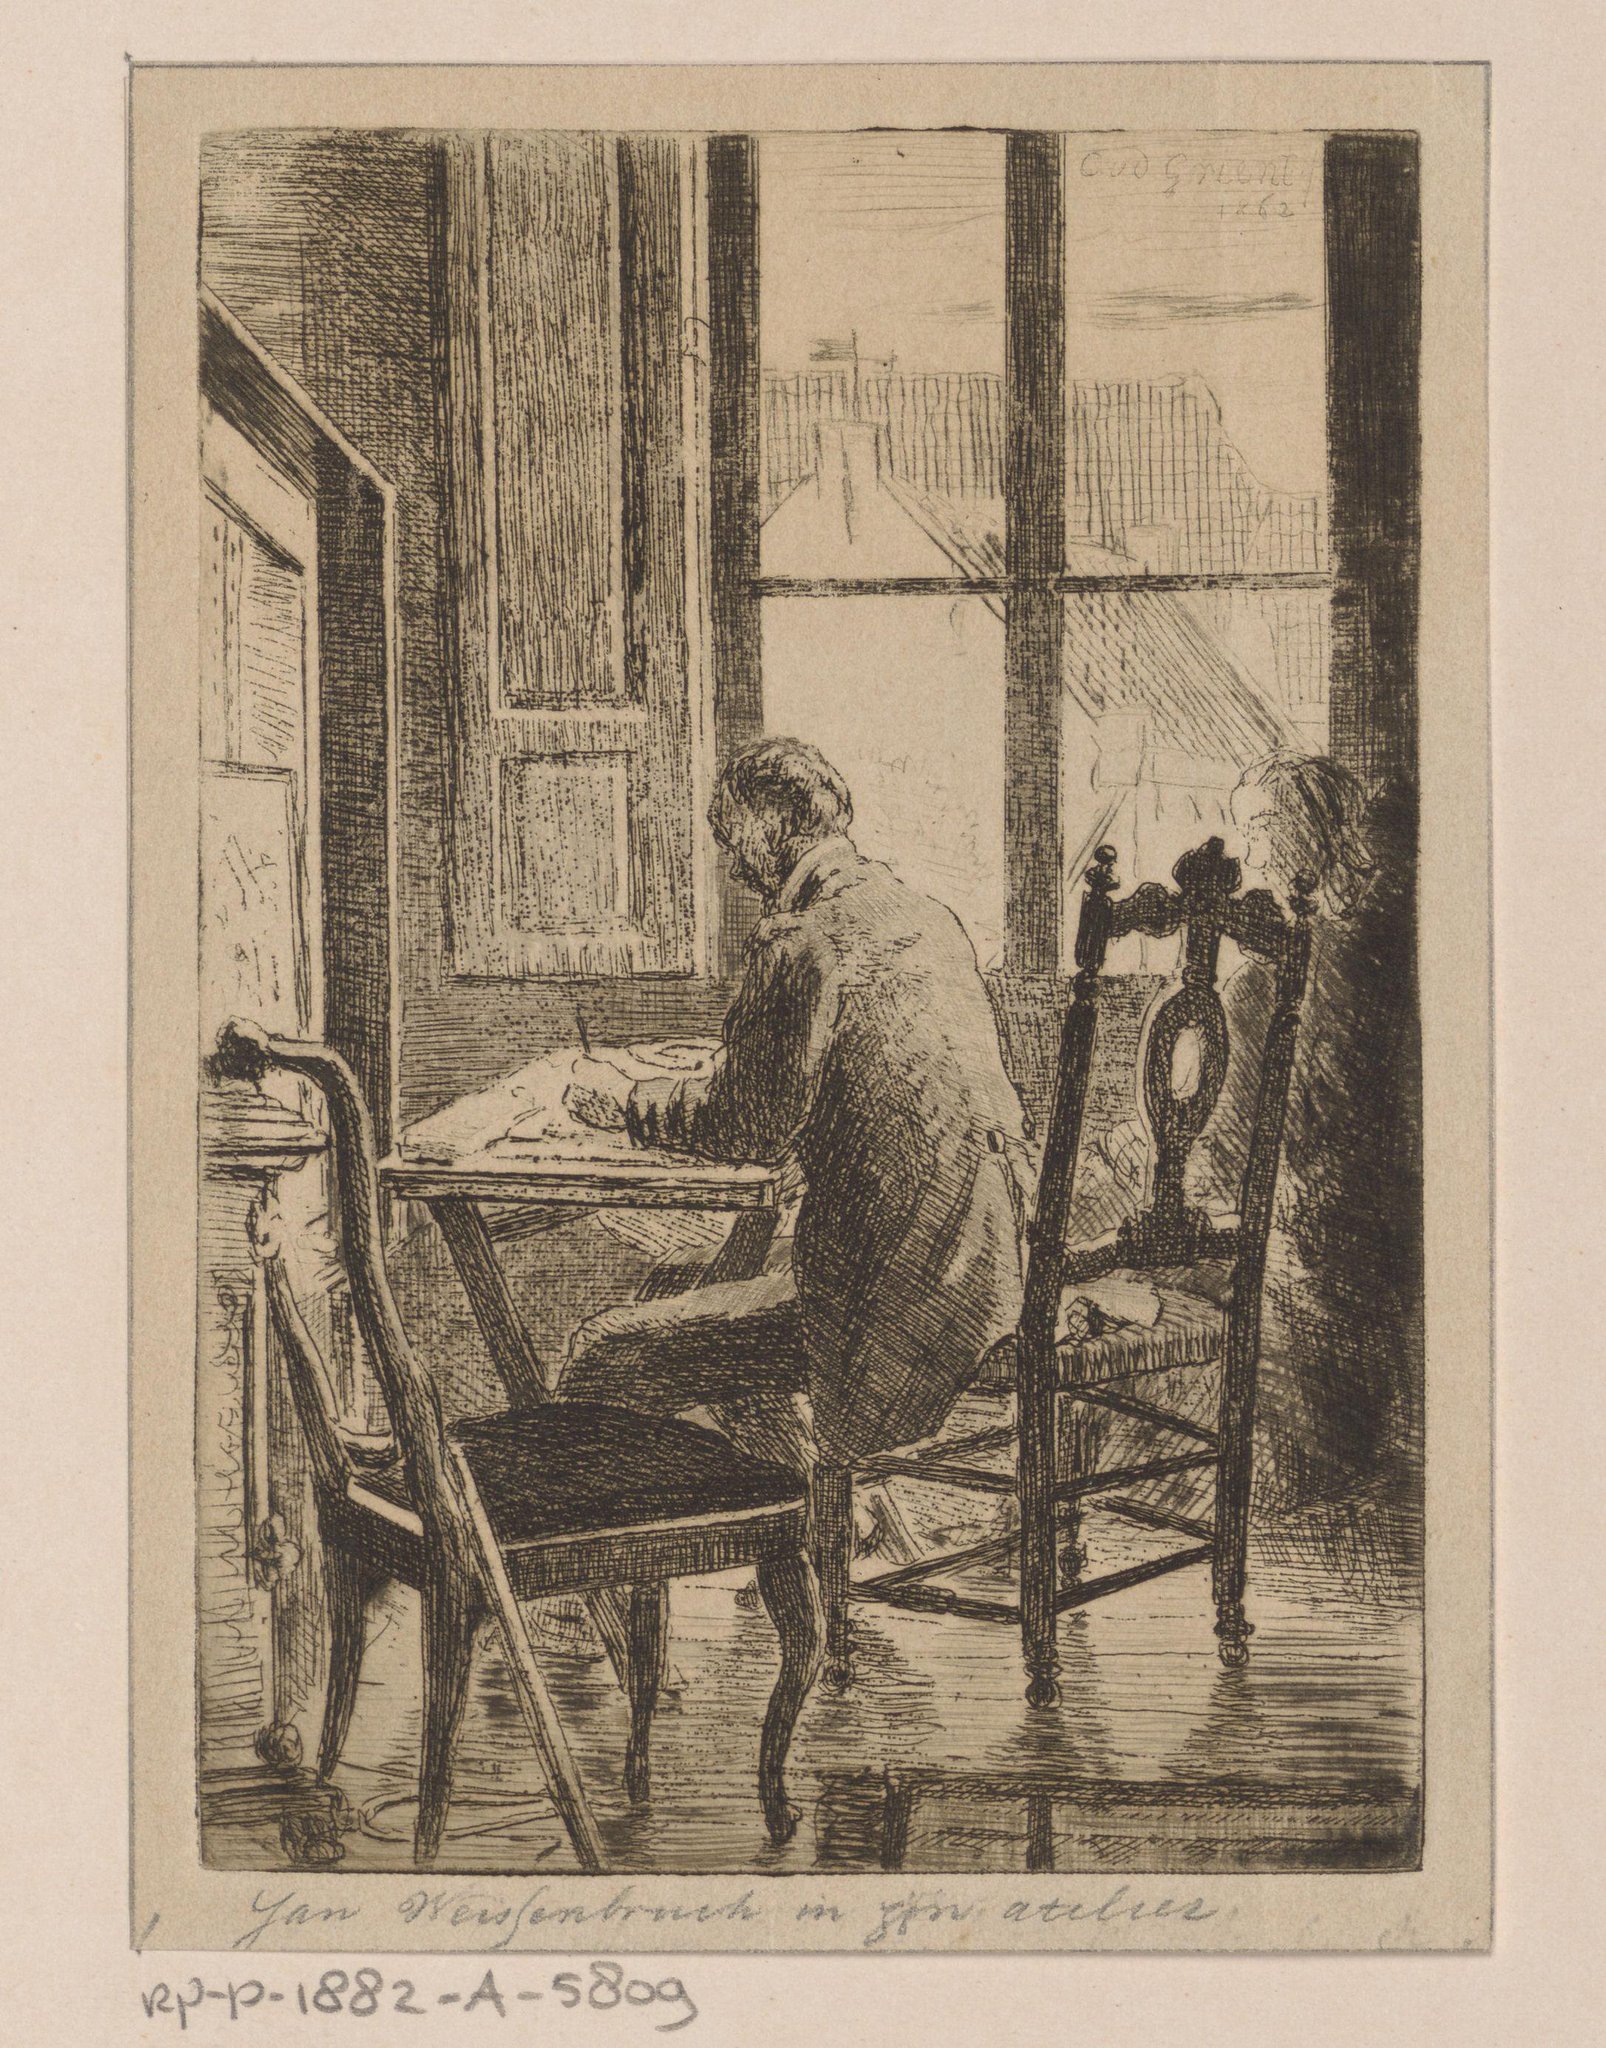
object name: print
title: Portret van Jan Weissenbruch in zijn atelier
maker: cornelis van der griendt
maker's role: draughtsman, painter, print maker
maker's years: 1827-1918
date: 1862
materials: paper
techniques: etching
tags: painter, print maker, jan weissenbruch, historical persons, portrait, self-portrait of graphic artist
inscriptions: collector's mark: Lugt 2228